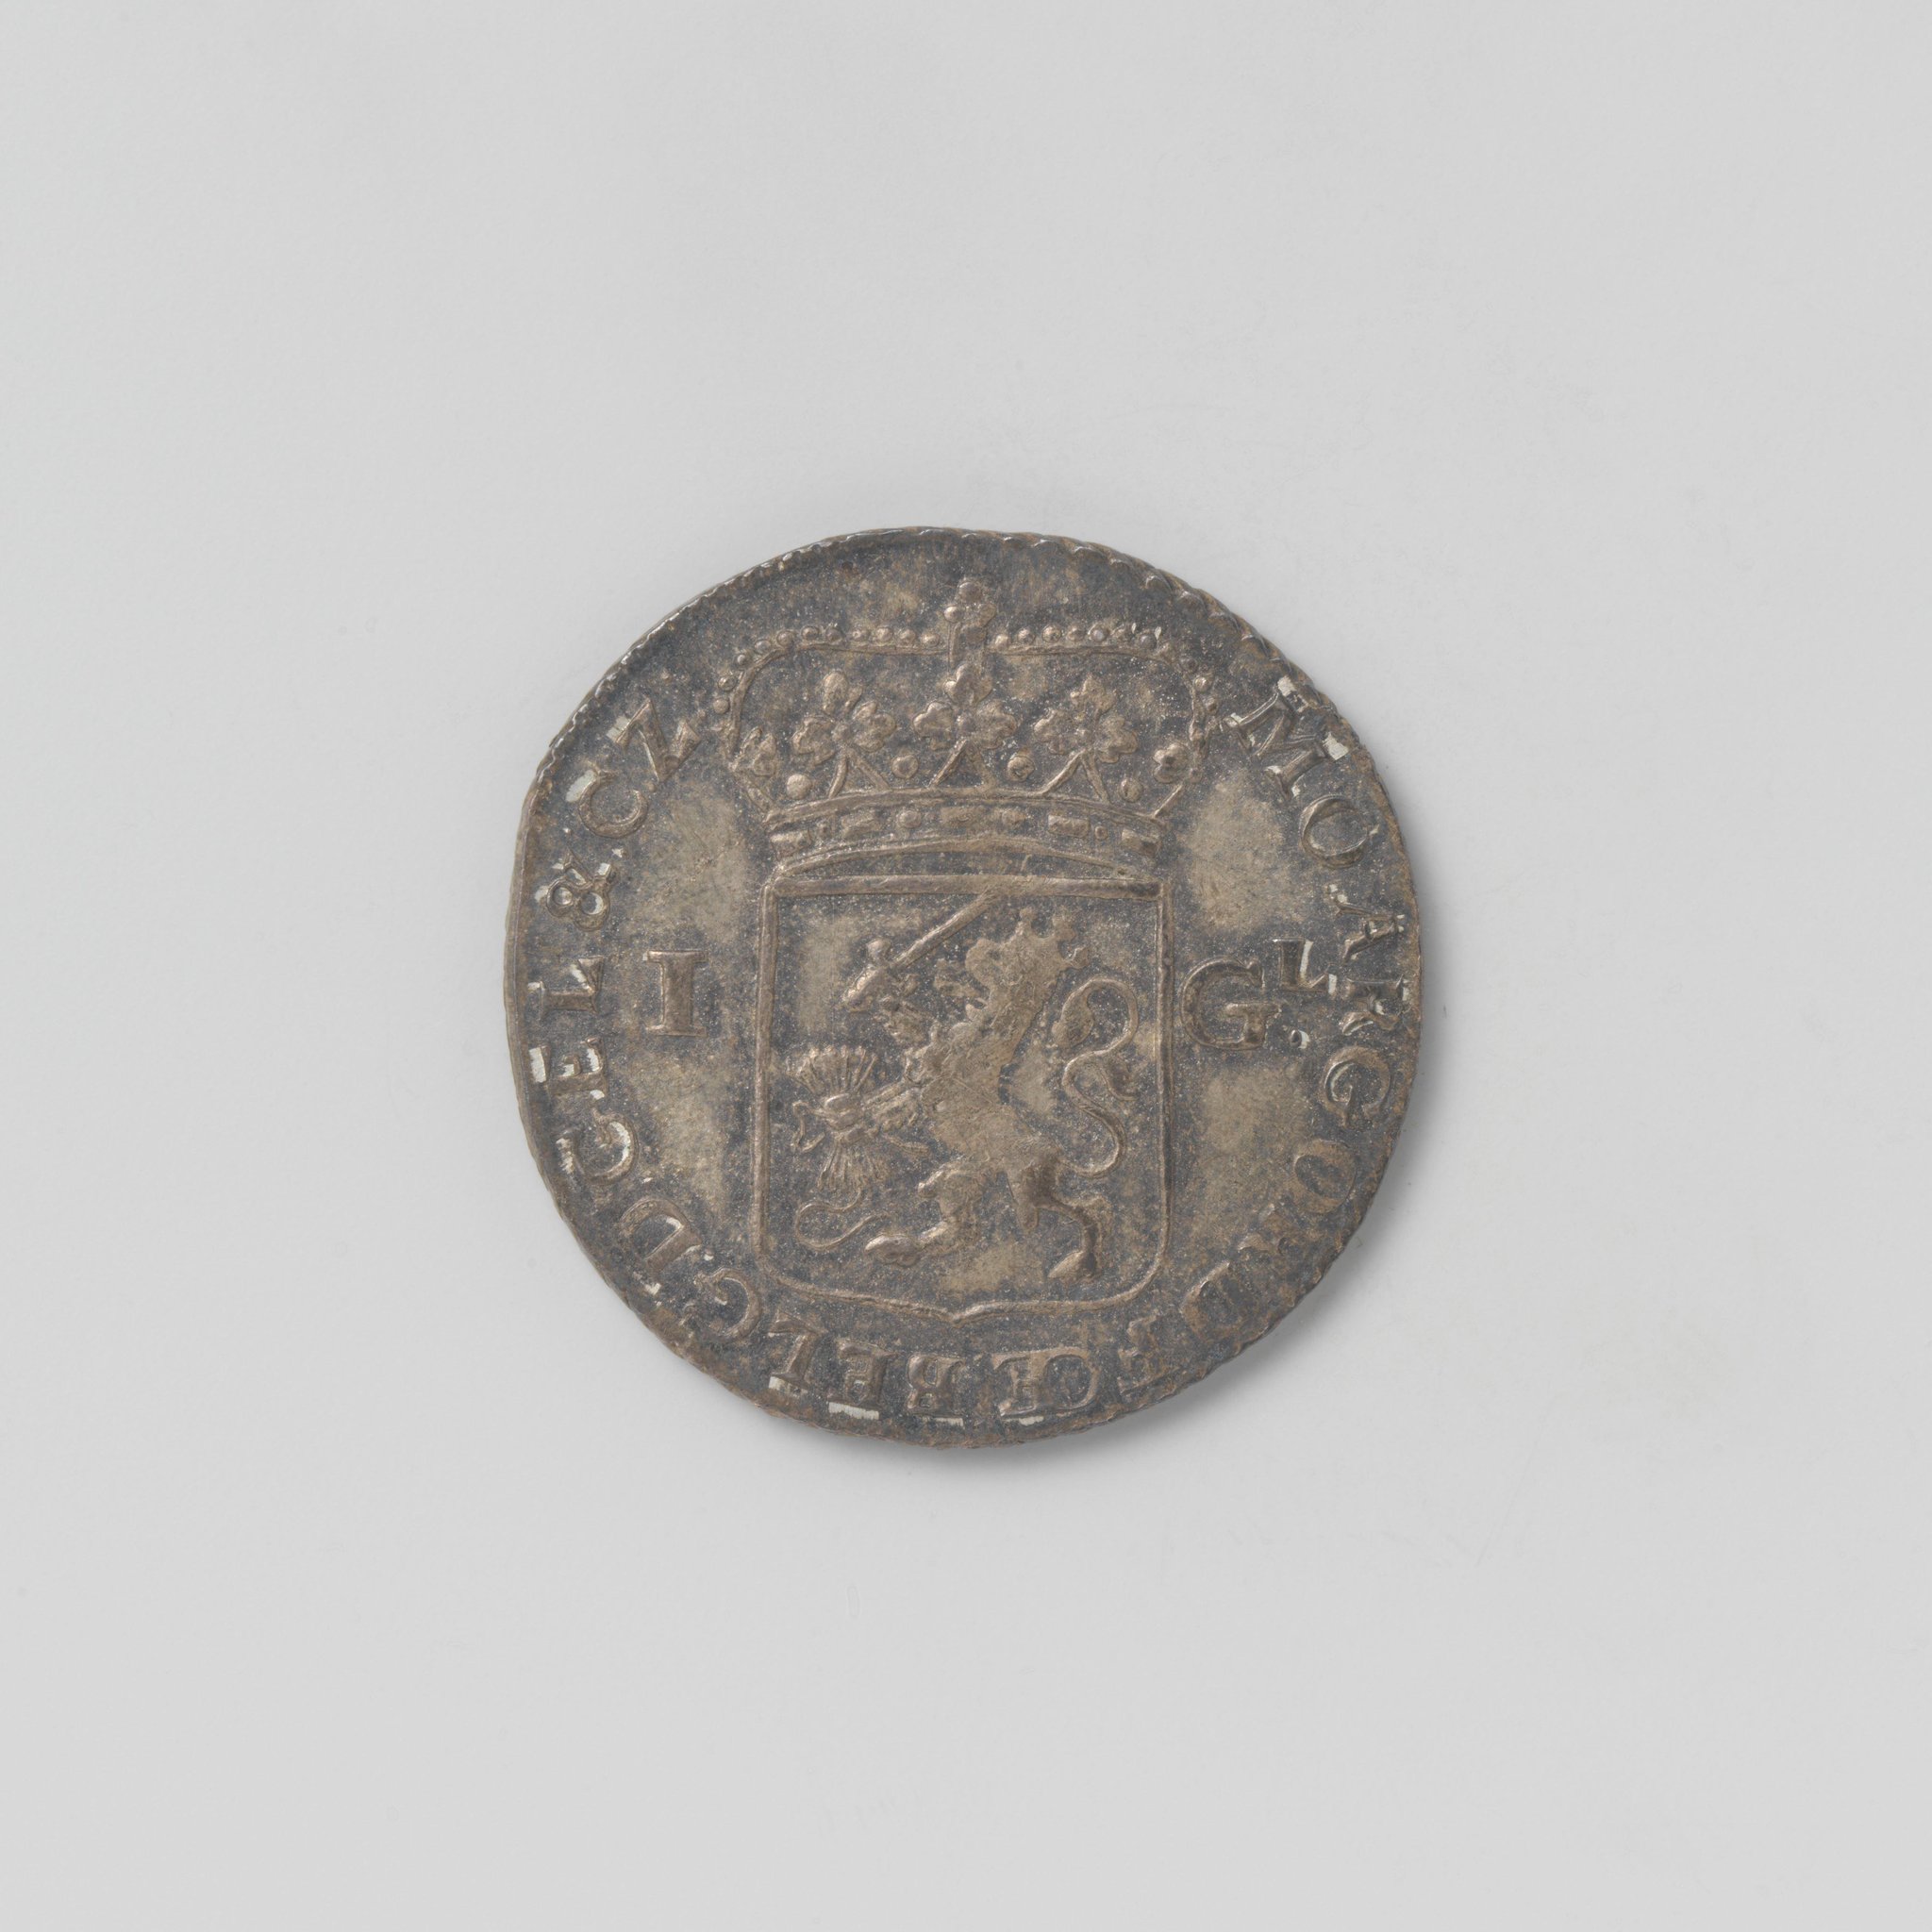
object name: coin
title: Gelderland, gulden, 1786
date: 1786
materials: silver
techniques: striking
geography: harderwijk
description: Zilveren munt. Voorzijde: tussen waarde-aanduiding gekroond generaliteitswapenschild. Keerzijde: staande Nederlandse maagd, in rechterhand lans met hoed, met linkerhand steunend op pilaar, waarop bijbel. In afsnede jaartal.